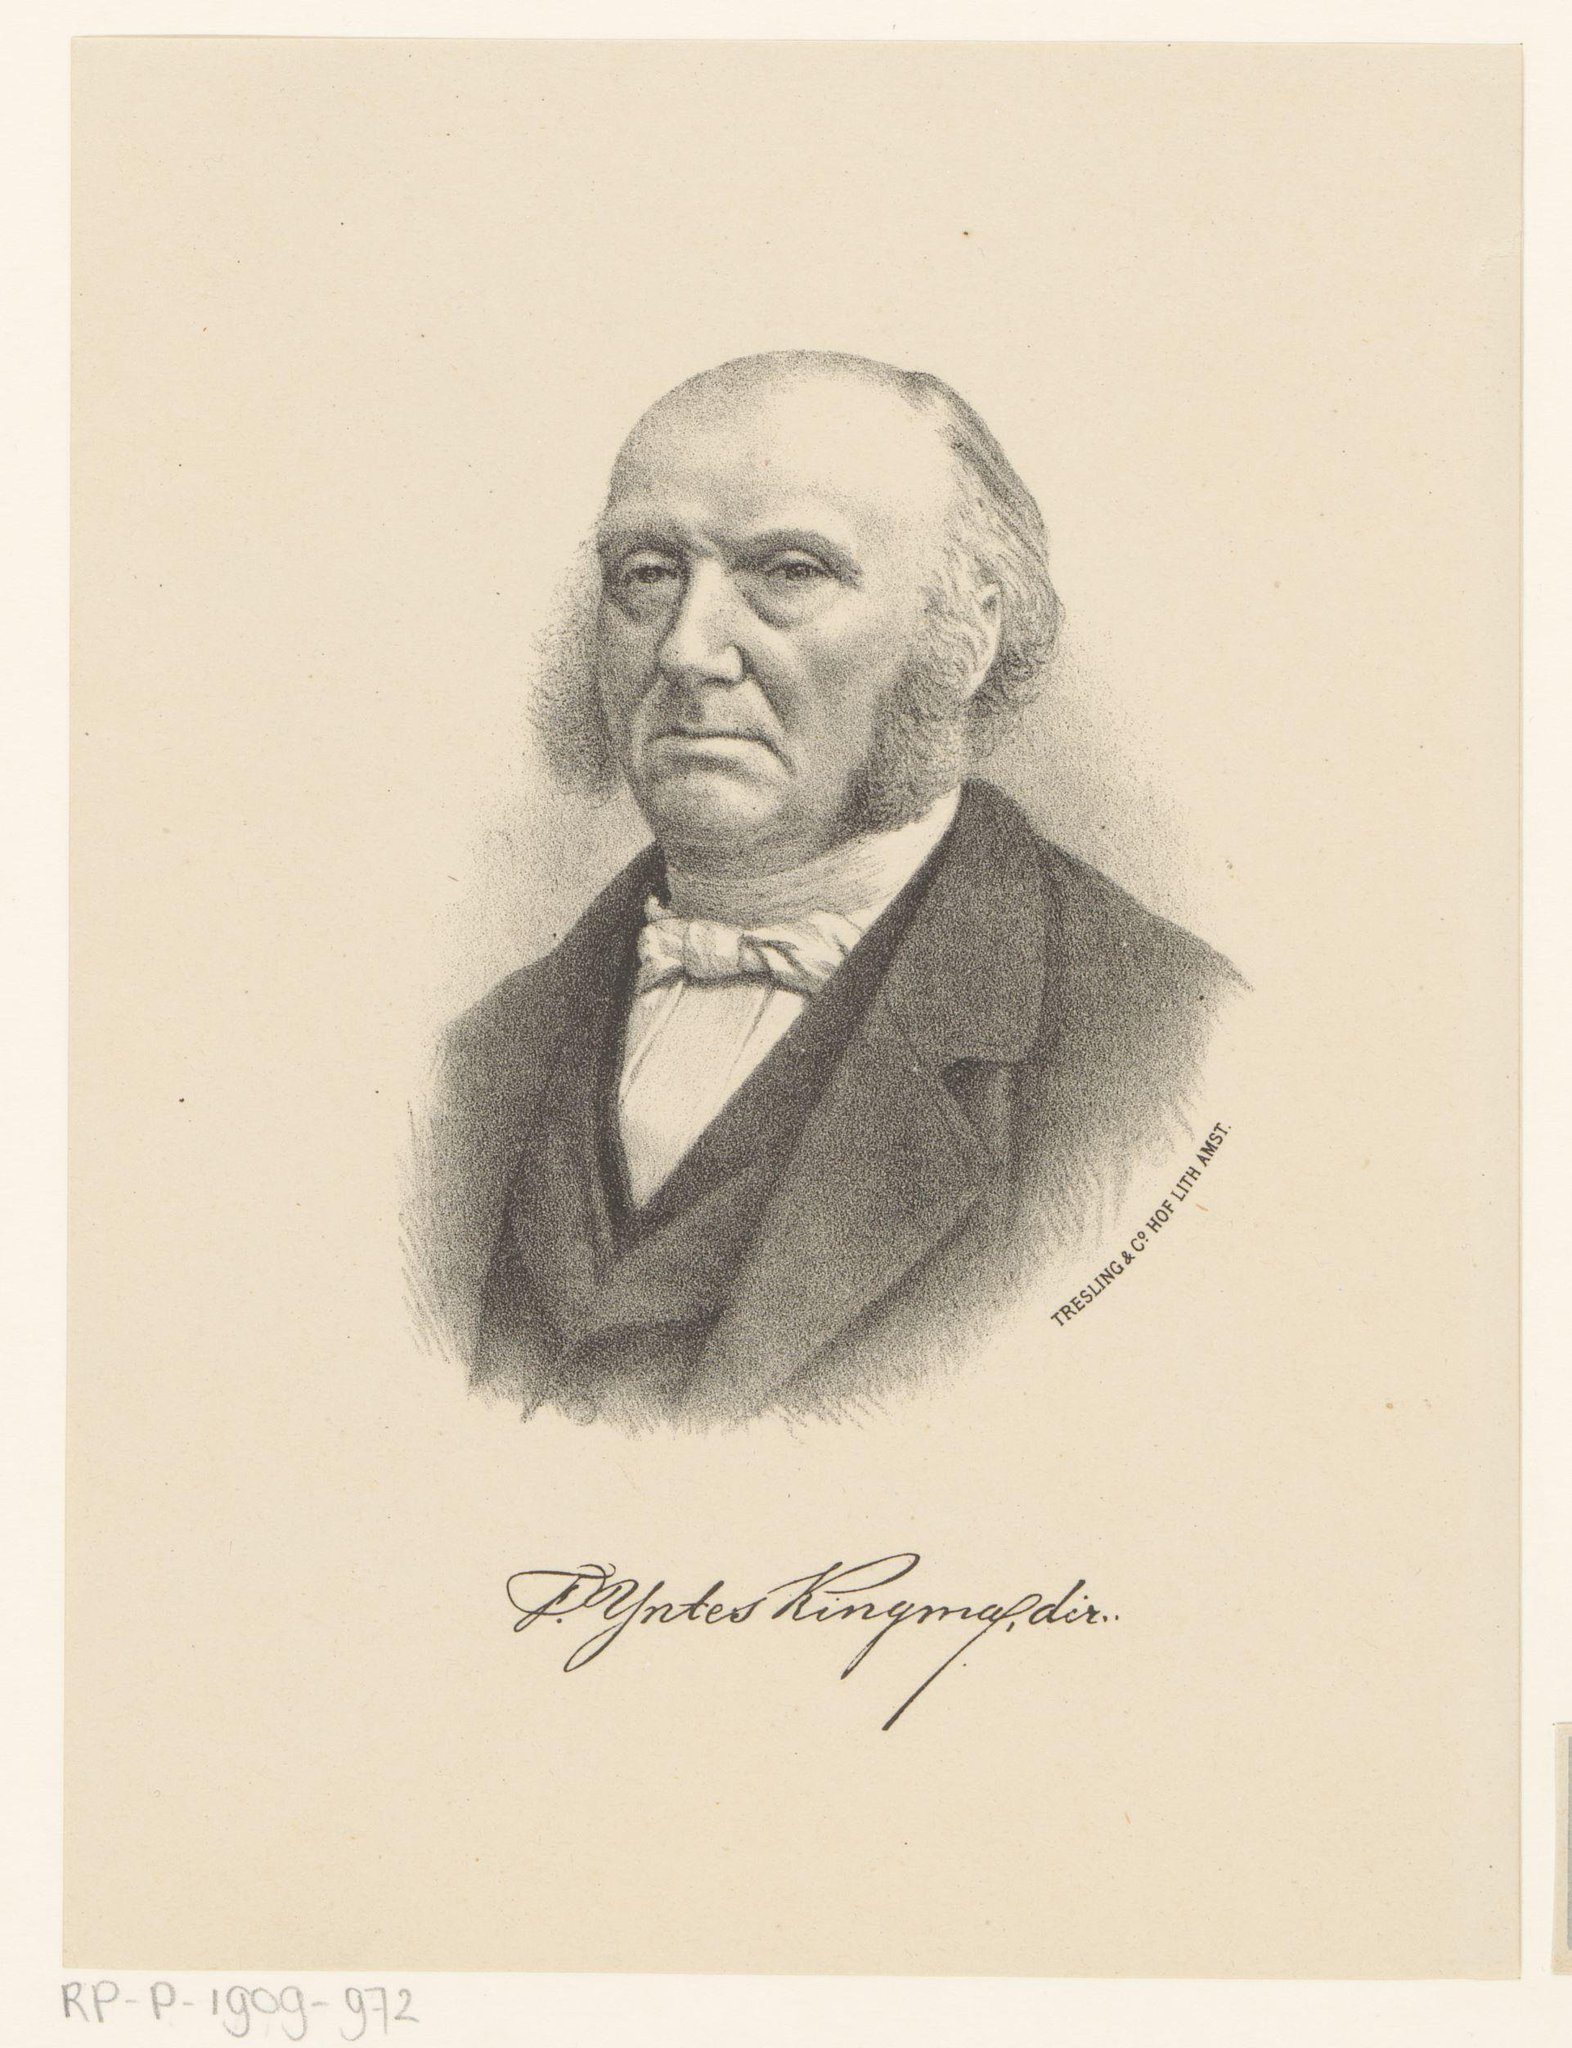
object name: print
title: Portret van Fokke Yntes Kingma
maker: Anonymous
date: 1858-1883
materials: paper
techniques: lithograph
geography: amsterdam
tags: historical persons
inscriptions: collector's mark: Lugt 2228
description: Onder het portret de signatuur van de geportretteerde.